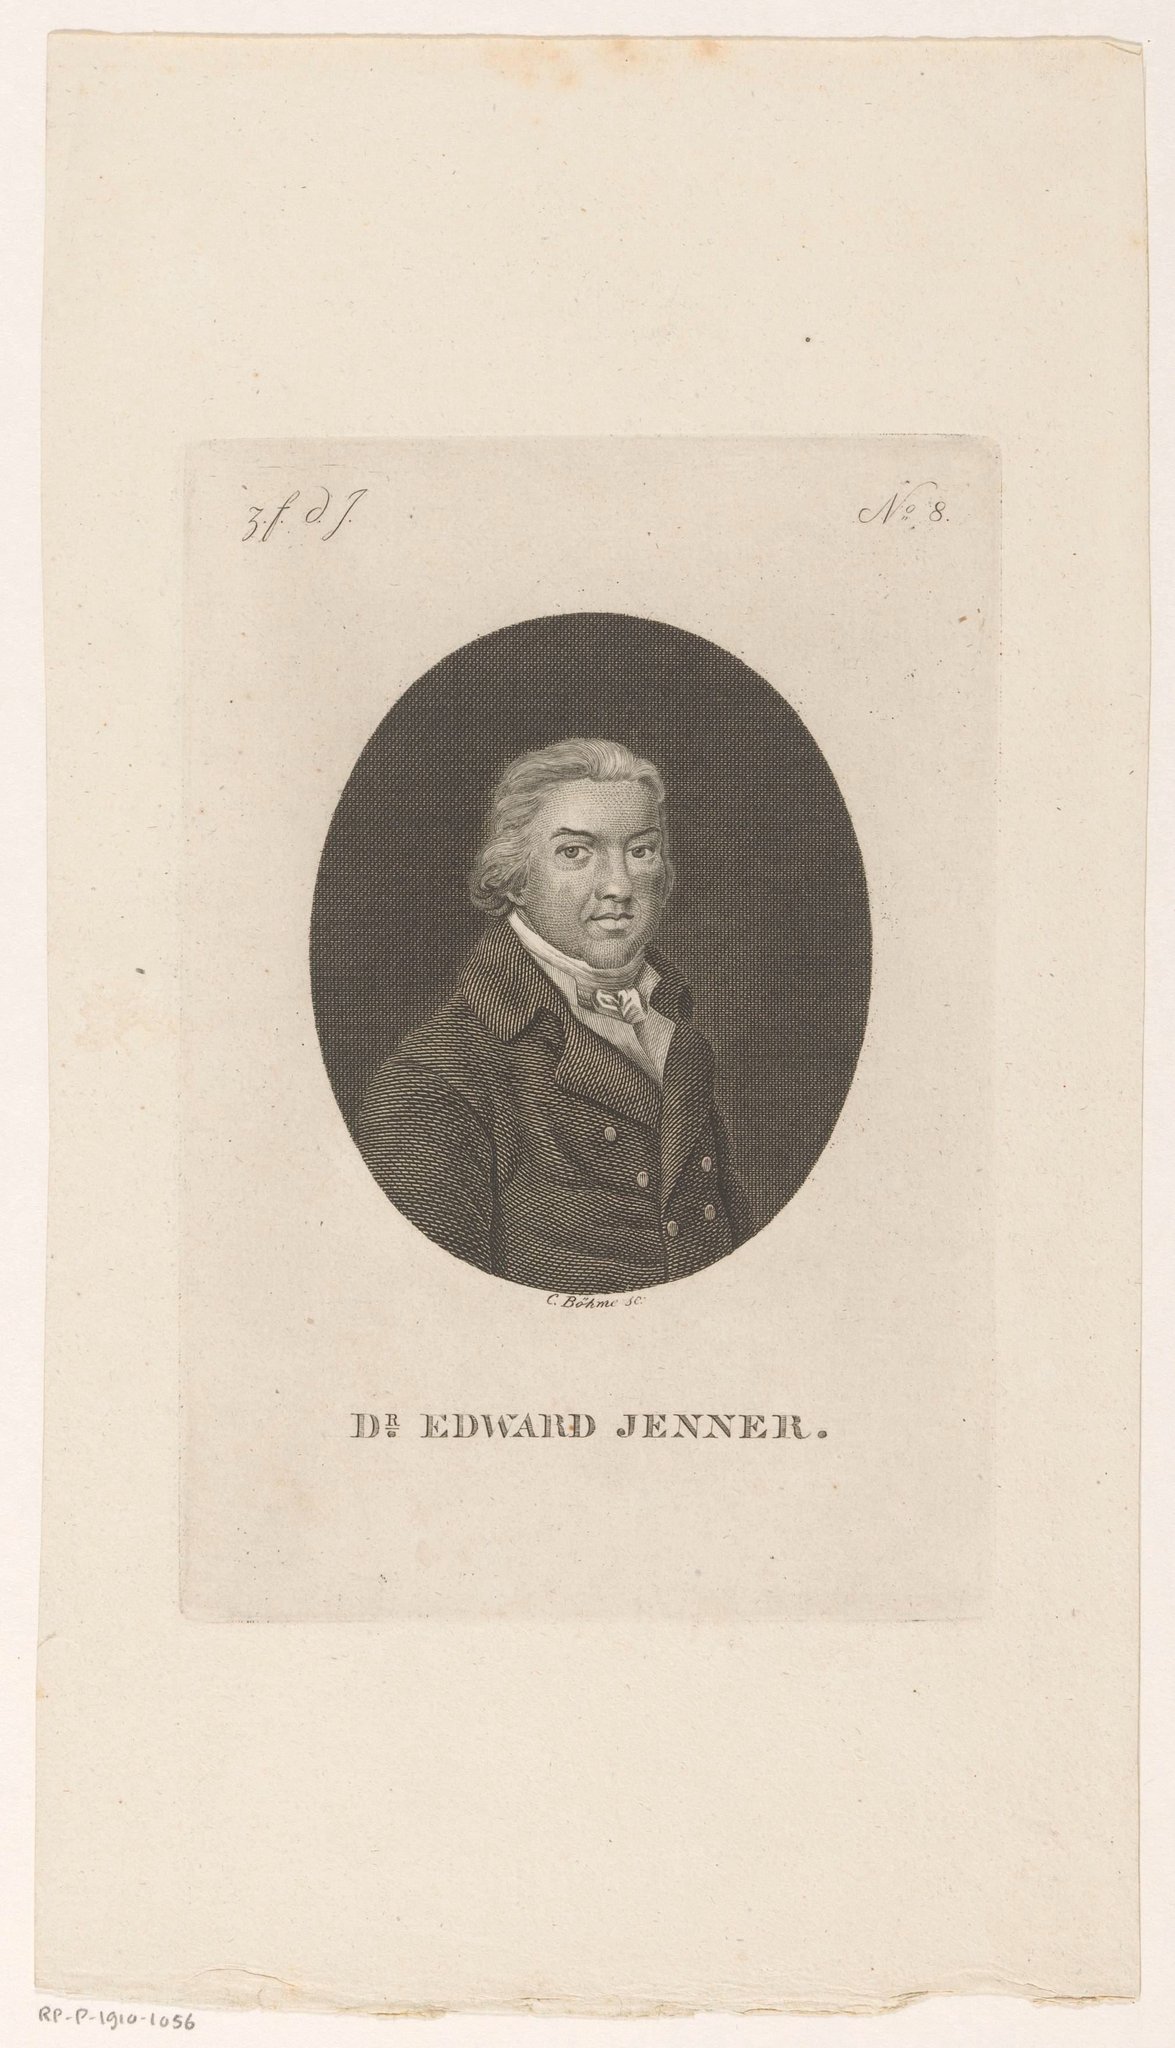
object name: print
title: Portret van Edward Jenner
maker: johann christiaan böhme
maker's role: print maker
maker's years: 1771-1835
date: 1781-1835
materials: paper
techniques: engraving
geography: leipzig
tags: historical persons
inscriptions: collector's mark: Lugt 2228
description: Rechtsboven genummerd: No. 8; linksboven: z.f.d.j.